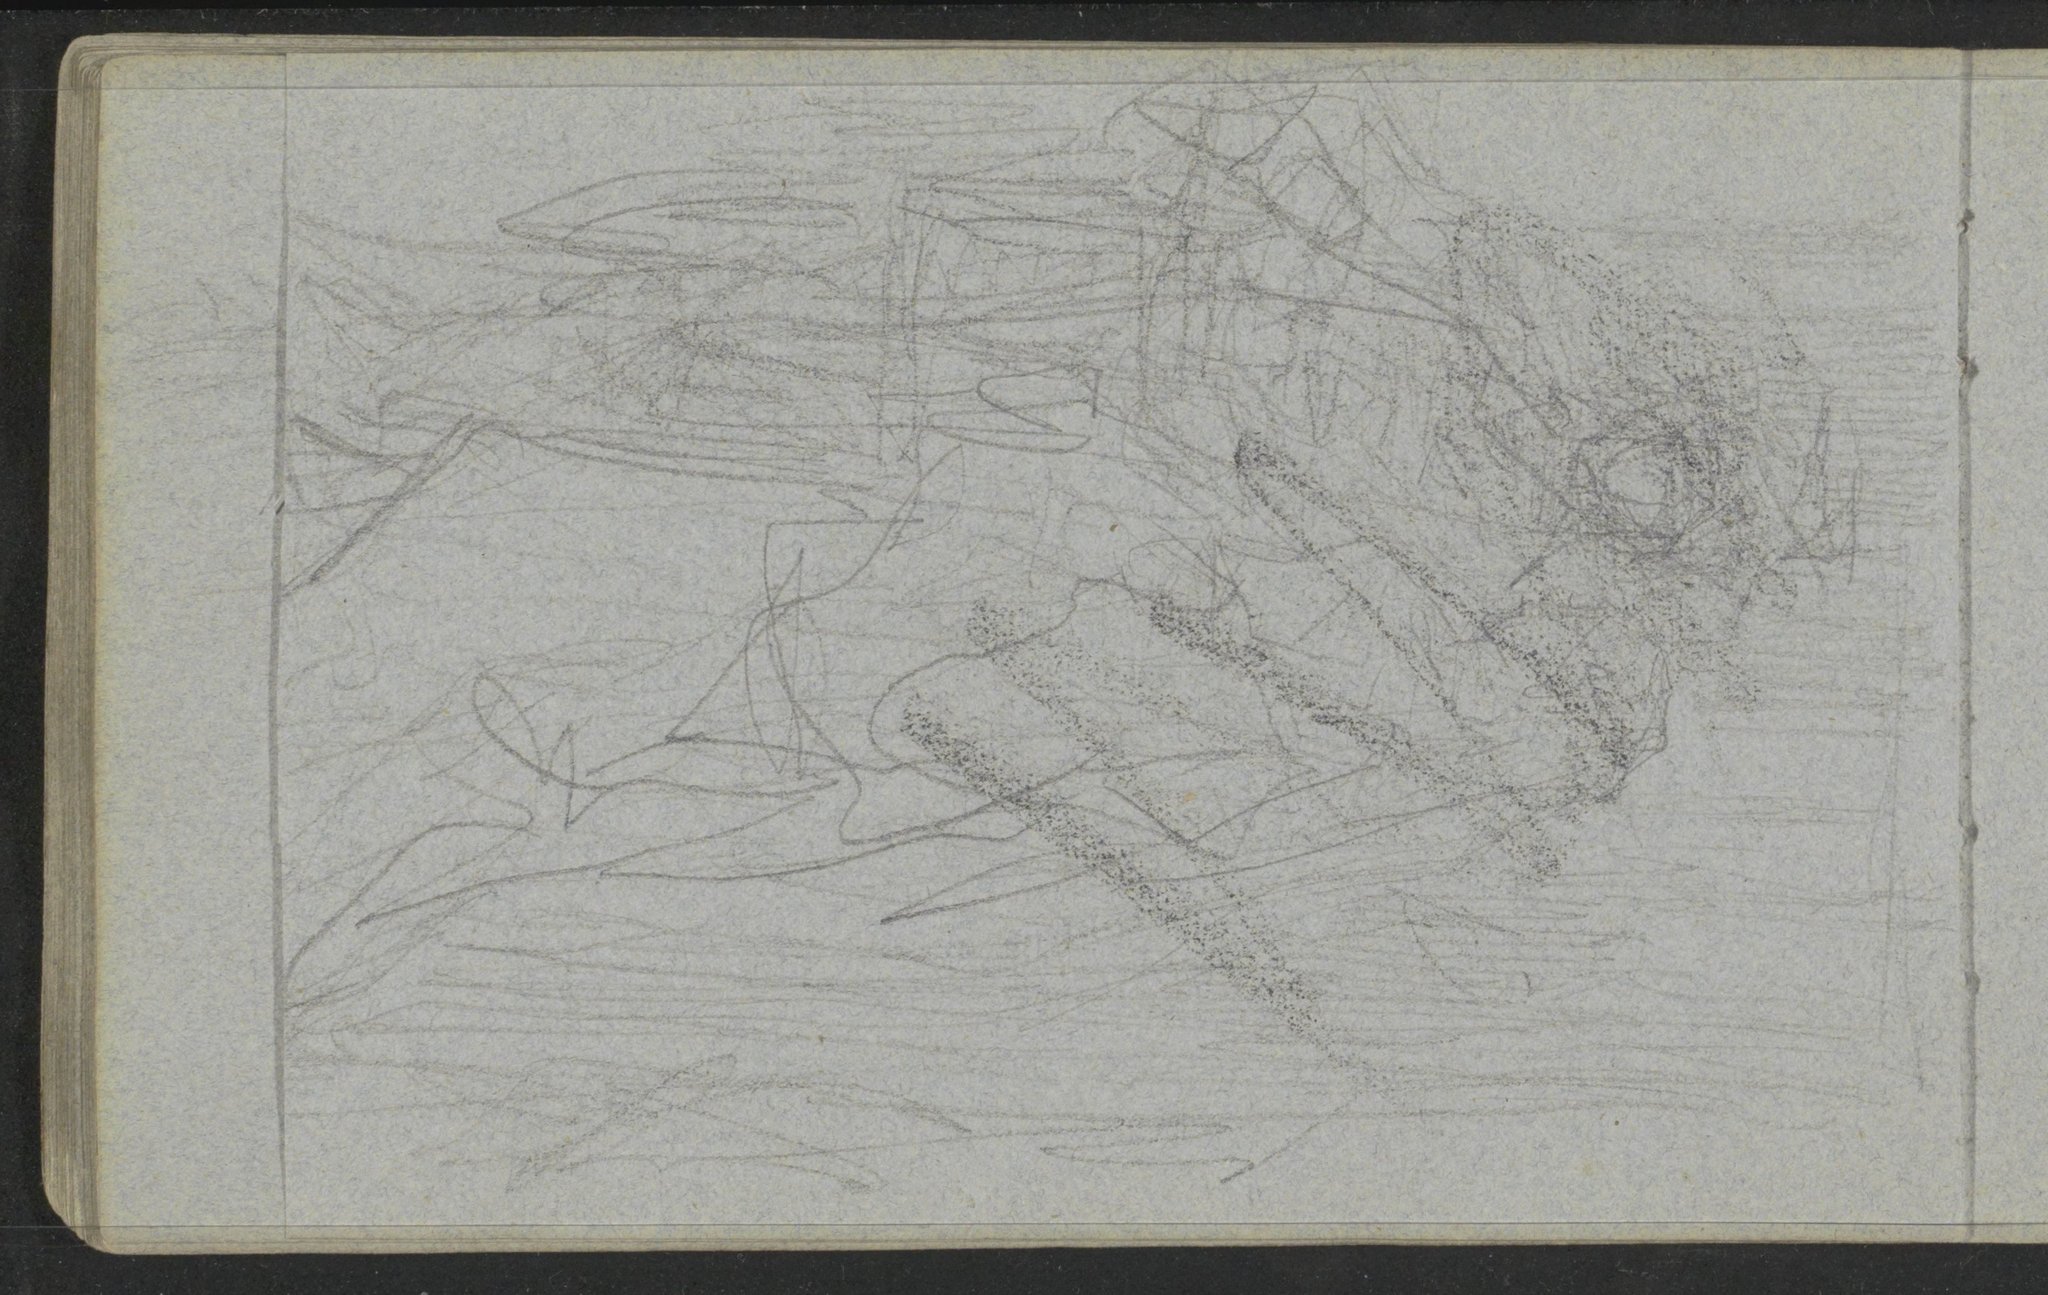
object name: sketchbook leaf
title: Studie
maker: matthijs maris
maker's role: draughtsman, painter, print maker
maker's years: 1839-1917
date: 1849-1917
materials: chalk, paper, pencil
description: Blad 21 verso uit een schetsboek met 35 bladen.